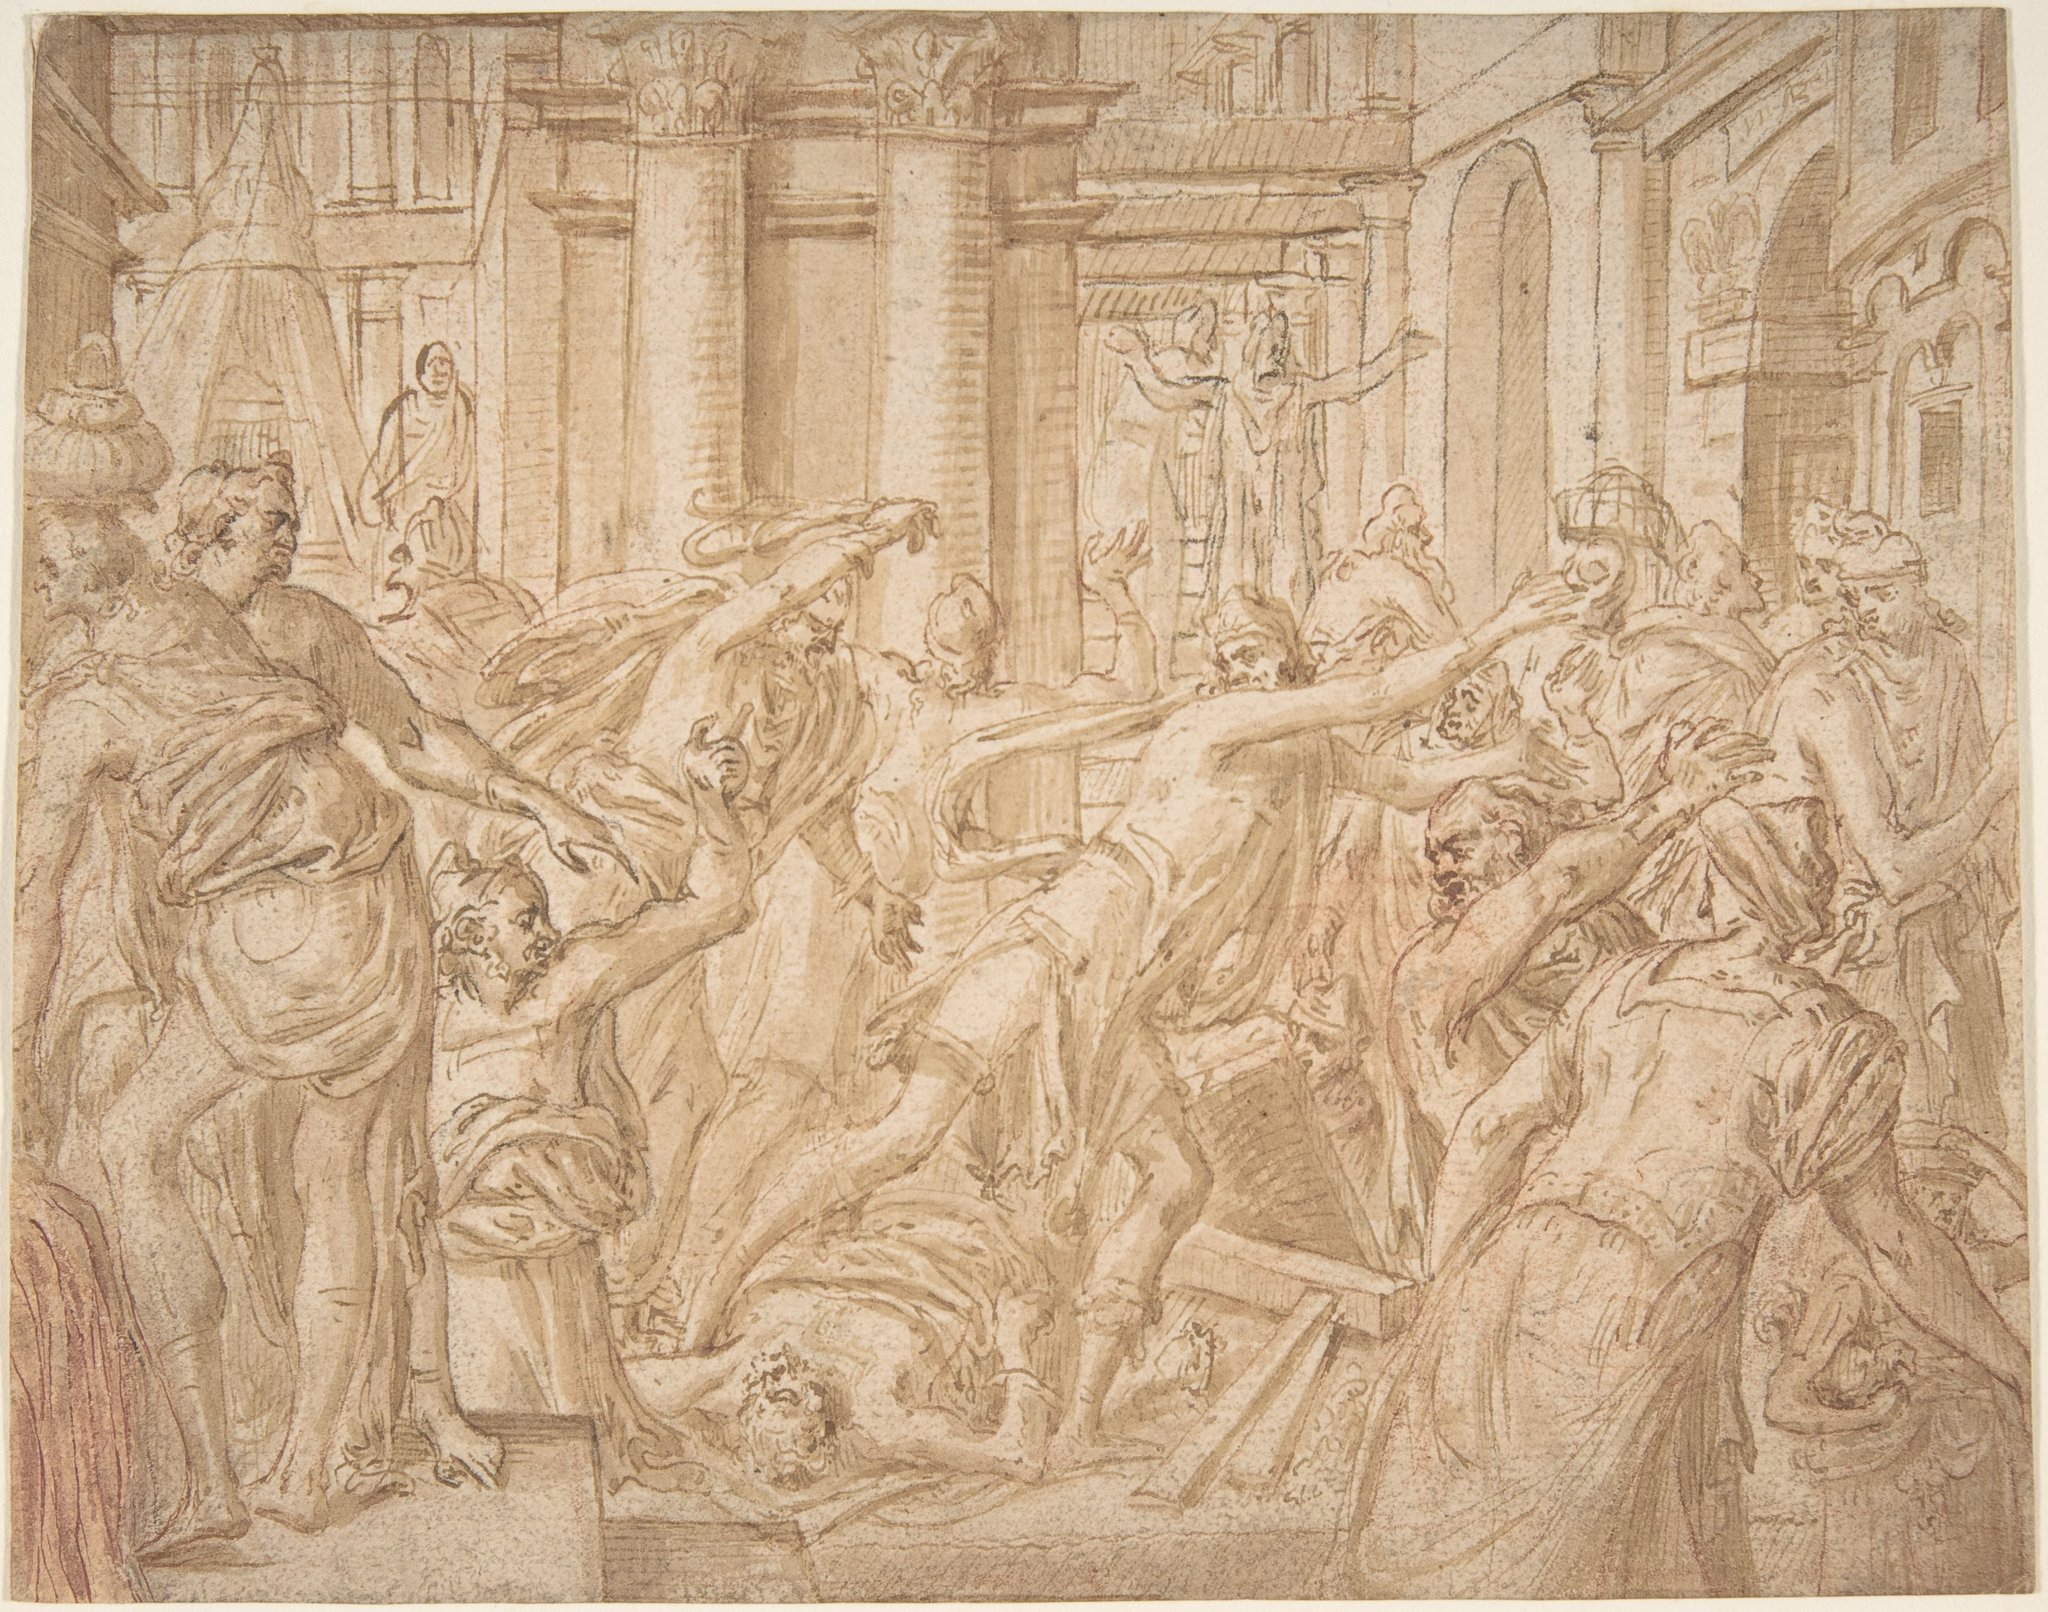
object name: drawing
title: Christ Driving the Money Changers from the Temple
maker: frans floris i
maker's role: artist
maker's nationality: netherlandish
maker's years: 1519-1570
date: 1530-1570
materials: chalk, ink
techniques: brush, pen, wash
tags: men,christ